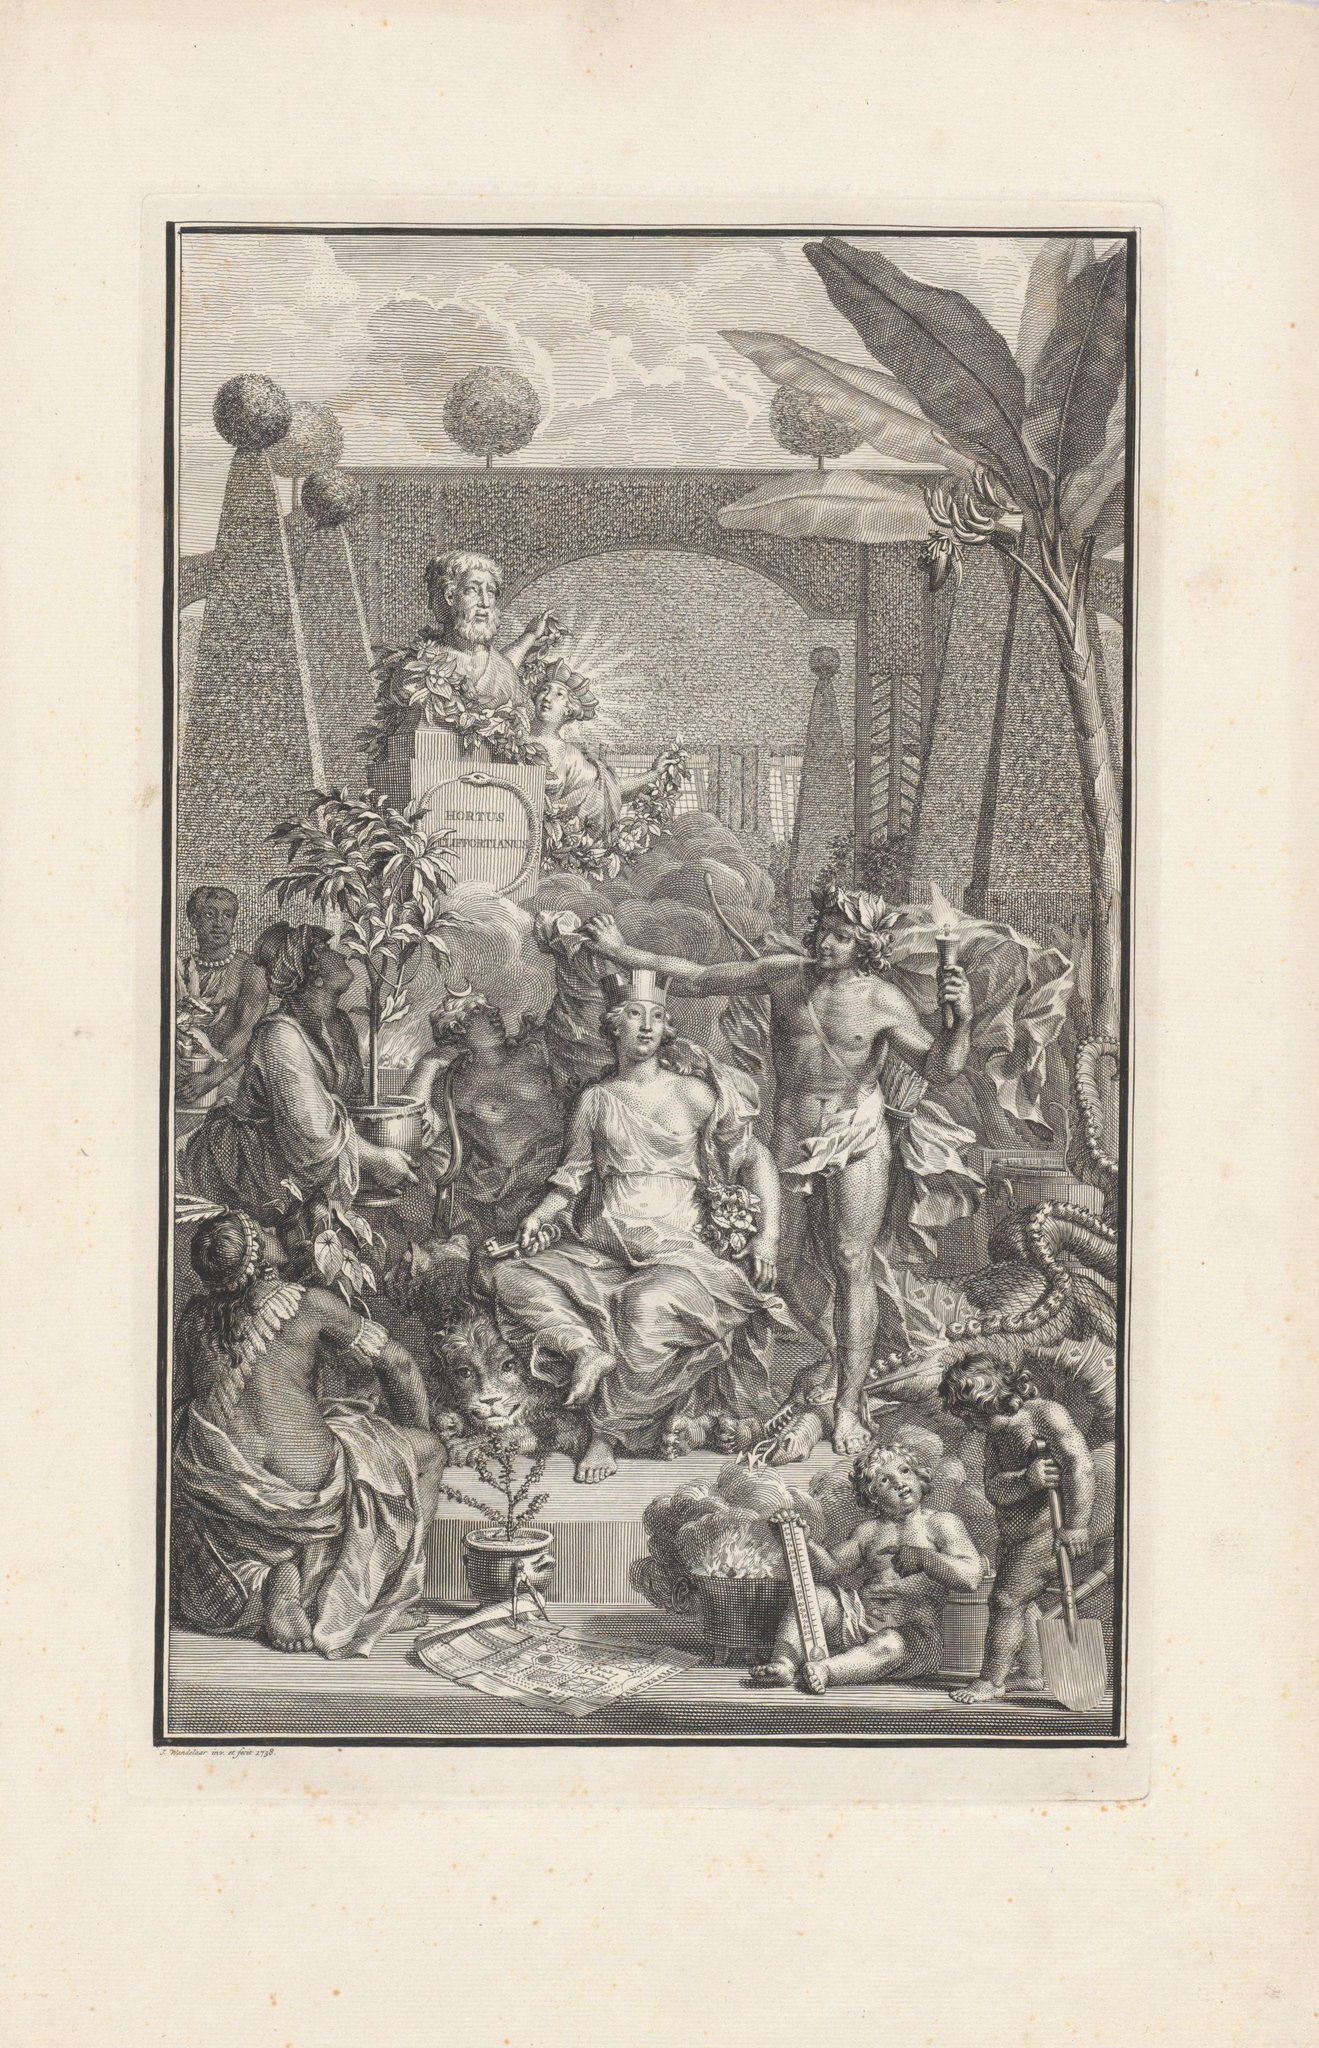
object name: titelblad, titelpagina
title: Diverse allegorische figuren in de tuin van George Clifford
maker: jan wandelaar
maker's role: draughtsman, print maker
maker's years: 1690-1759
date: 1738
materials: paper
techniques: engraving, etching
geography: warmond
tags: asiatic races and peoples, (story of) diana (artemis), (story of) cybele, rhea cybele, great mother of the gods (berecynt(h)ia), (story of) apollo (phoebus), maps, atlases, garden, africans, agricultural implements: spade, dragon, native peoples of the americas, plants and herbs, plants and herbs: aloe, thermometer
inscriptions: date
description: Allegorische titelpagina met in het midden de 'aardmoeder' Cybele, gezeten op een leeuw en een leeuwin, met de sleutels tot de tuin in haar hand. Aan haar voeten een pot met Cliffortia ilicifolia en daarbij een plattegrond van de tuin van de Hartekamp. Links biedt een Afrikaanse vrouw haar een Aloë uit Afrika aan, een vrouw met een tulband brengt haar een plant van de Coffea arabica uit Azië en een figuur met verentooi biedt Hernandia uit Amerika aan. Op een voetstuk waarop de titel in het Latijn, een buste van George Clifford(?). Aan de rechterzijde een bananenplant in bloei, en Apollo, die in zijn linkerhand een fakkel houdt en met zijn rechterhand de sluier van Diana optilt. Met zijn voeten vertrapt hij de draak der onwaarheid, een verwijzing naar de nagemaakte Hydra in Hamburg die Linnaeus op zijn reis naar Holland als bedrog had ontmaskerd. Rechts op de voorgrond twee putti met een thermometer en een spade.